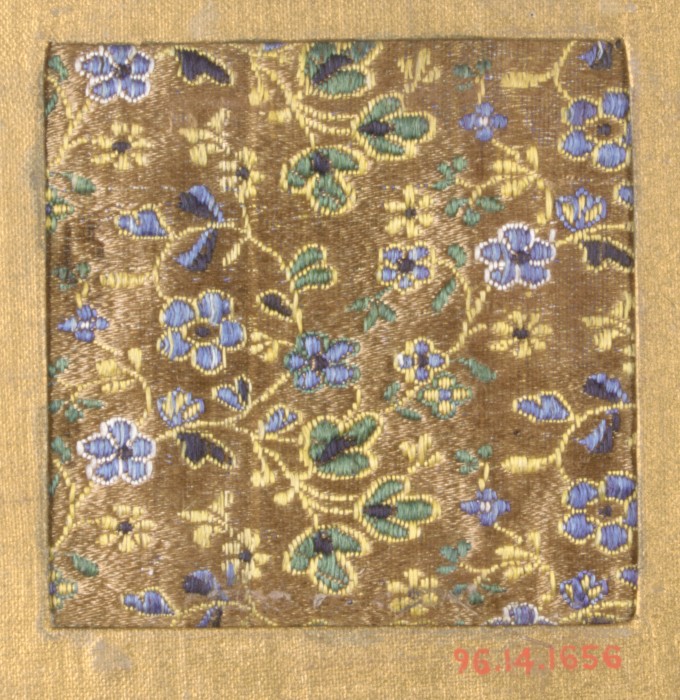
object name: piece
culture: japanese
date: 1701-1900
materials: silk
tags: leaves